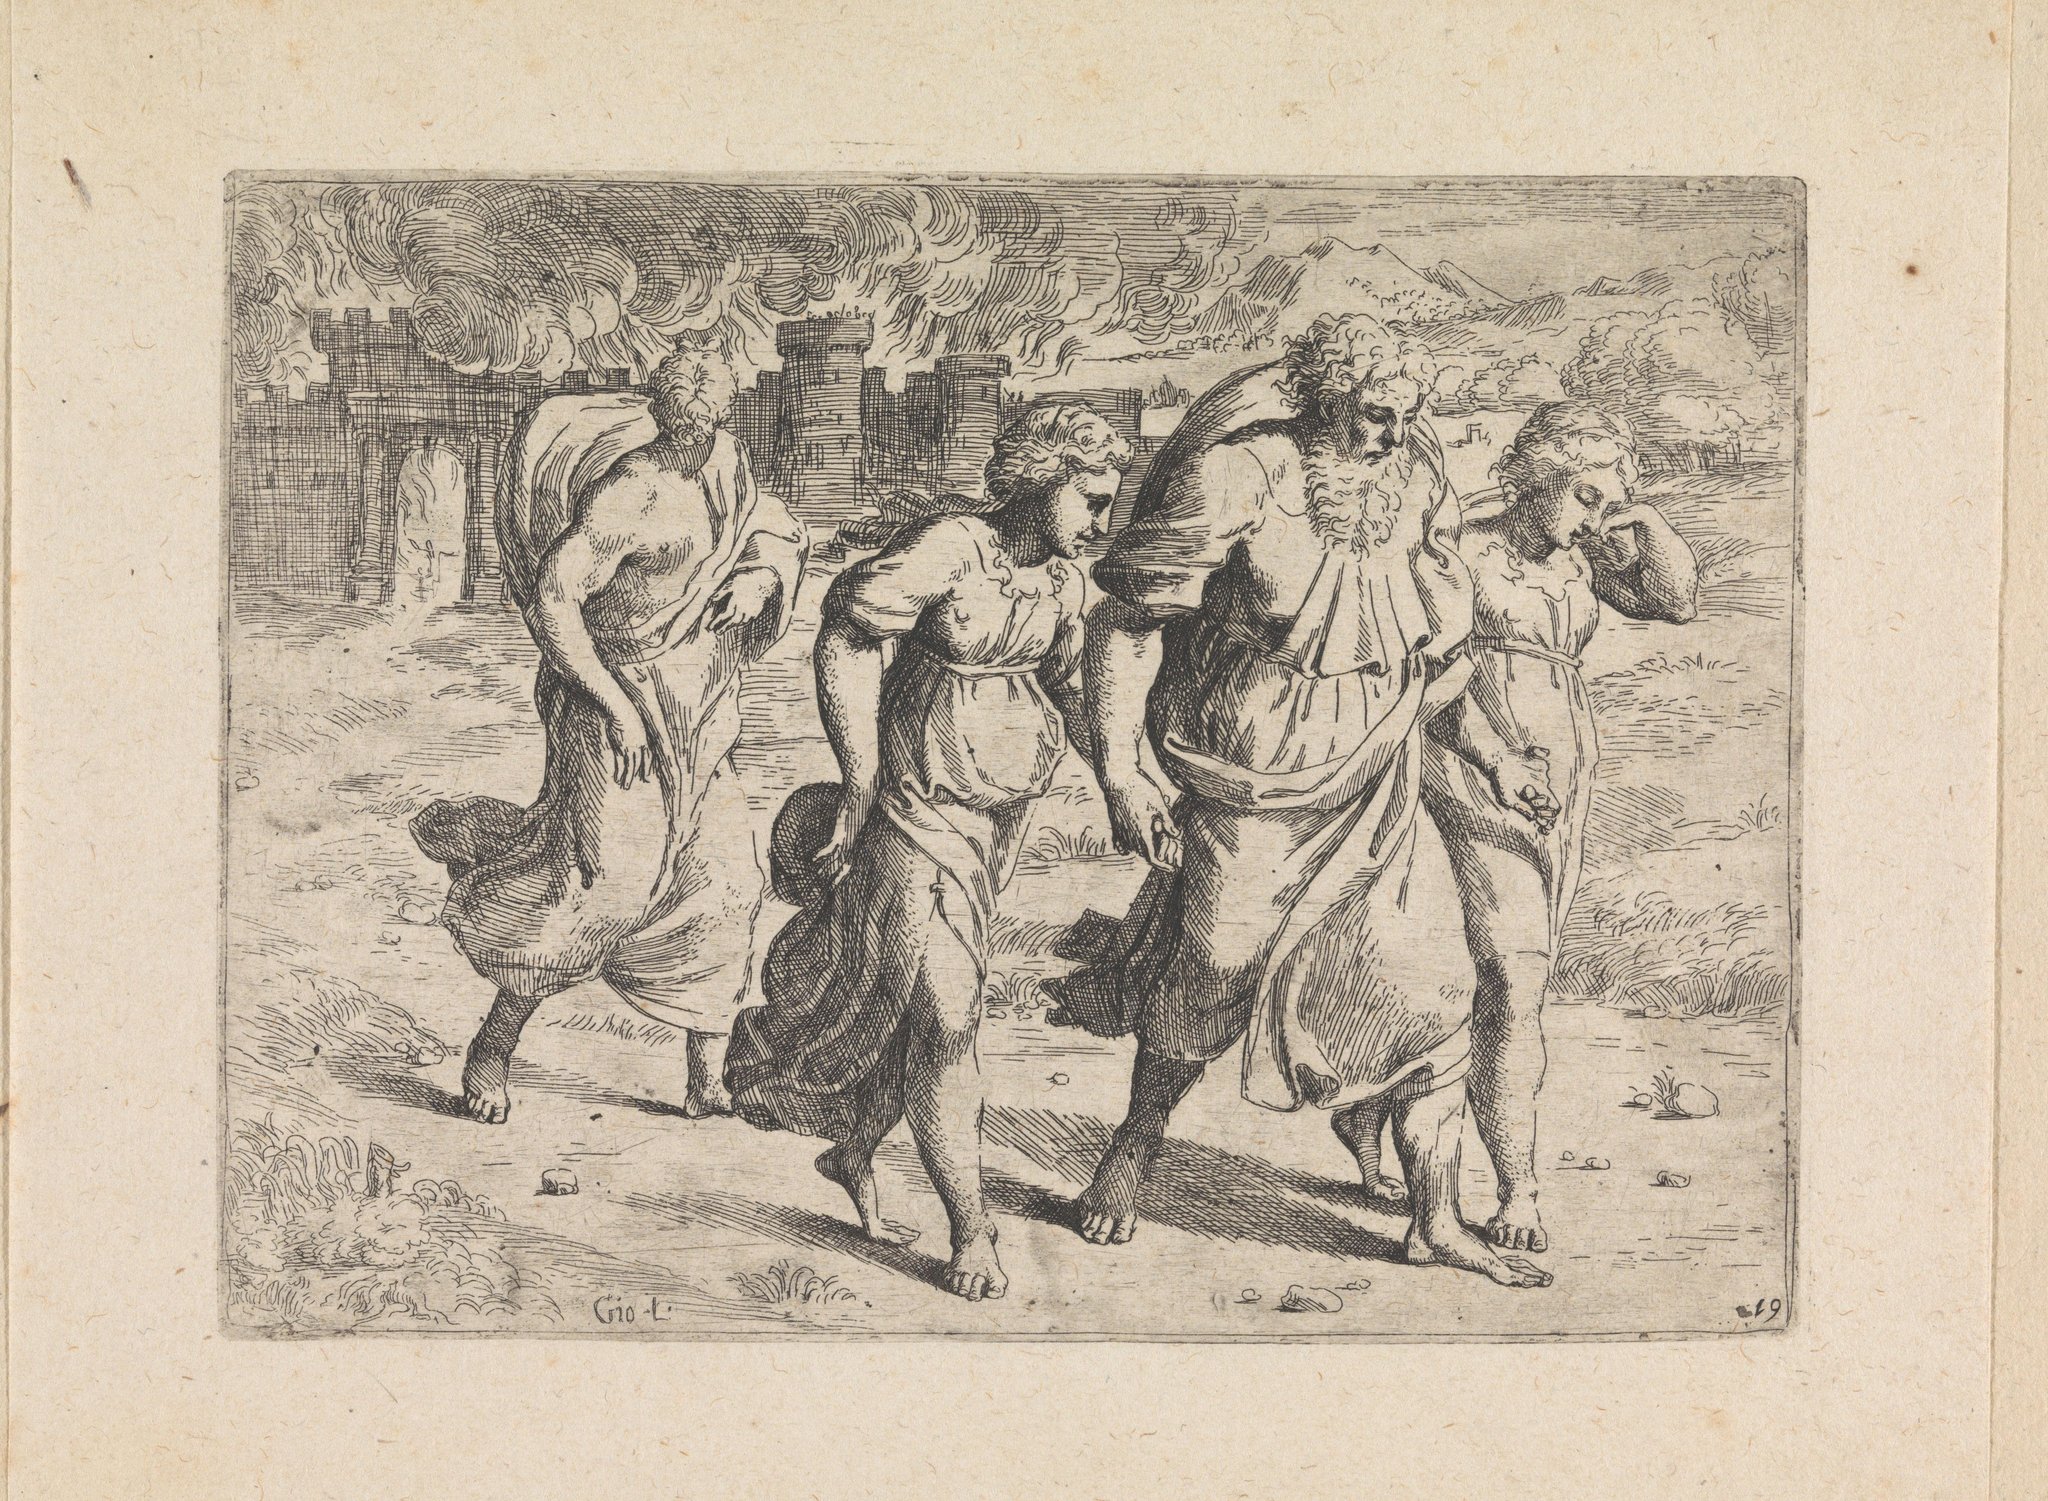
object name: print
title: Lot verlaat Sodom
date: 1607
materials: paper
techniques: etching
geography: rome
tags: the destruction of sodom and gomorrah: lot and his family flee to zoar, carrying their belongings; an angel may be showing the way (genesis 19:24-29)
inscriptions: collector's mark: Lugt 11, collector's mark: ‘Hinloopen’, number: ‘36’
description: Prent uit een reeks van 54 genummerde prenten naar schilderingen in de Loggia van Rafael in het Vaticaan.